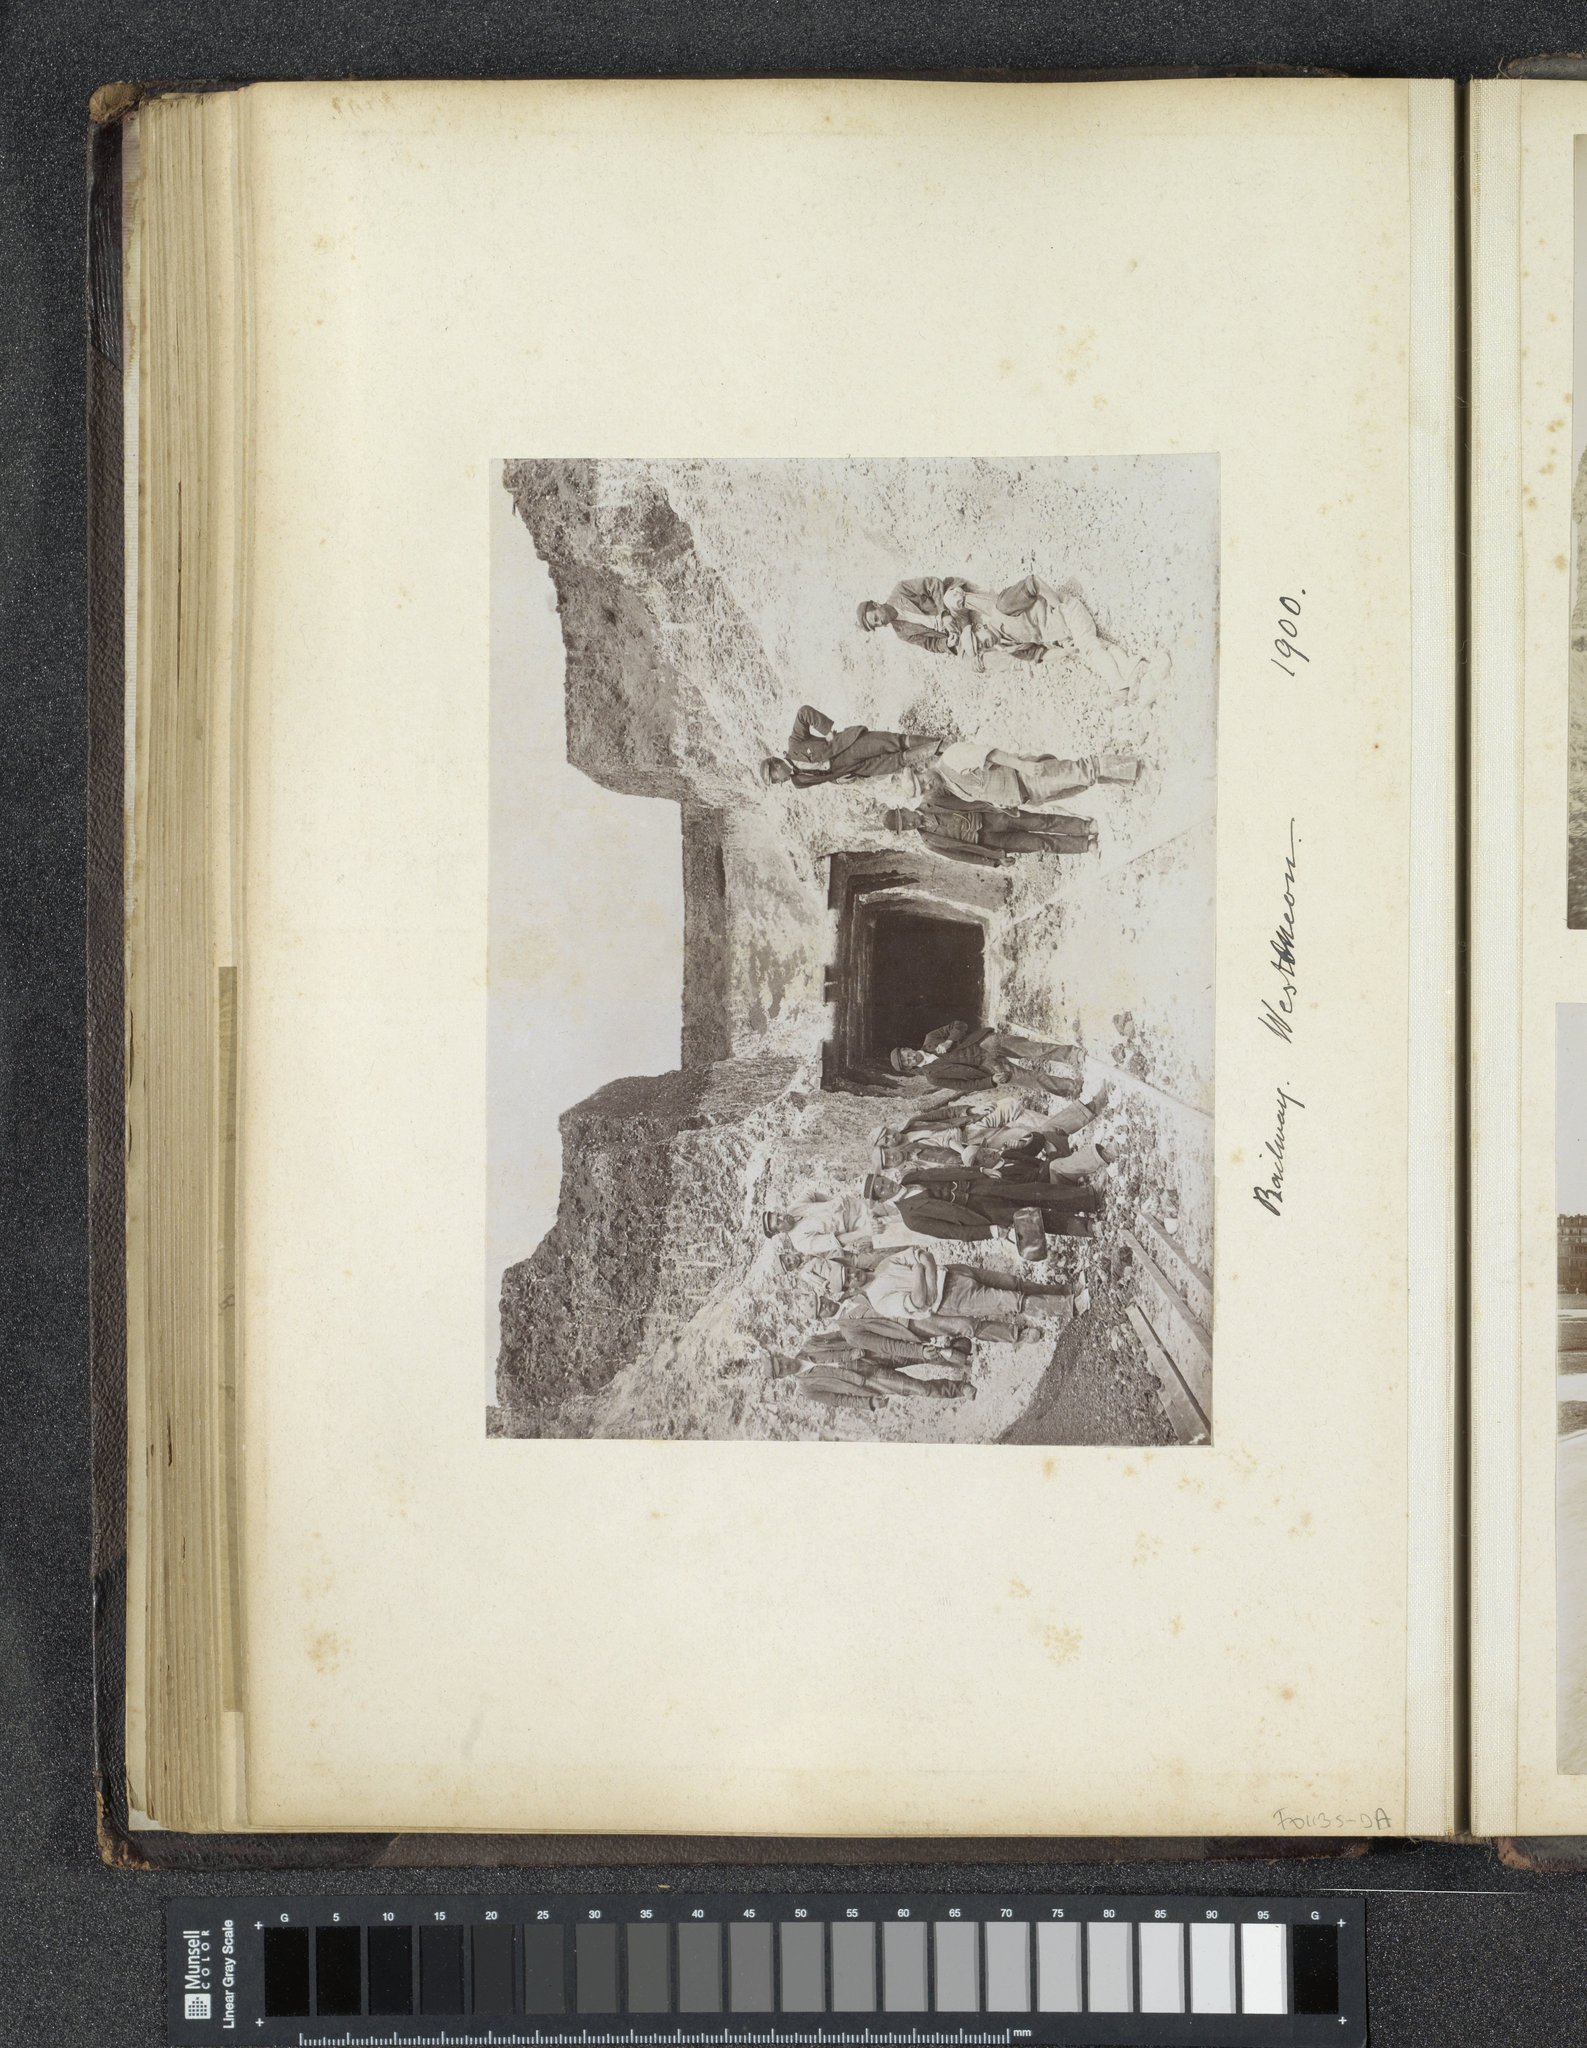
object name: photograph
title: Groep mannen bij een spoorwegtunnel in aanleg bij West Meon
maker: Anonymous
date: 1900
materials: paper, photographic support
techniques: albumen print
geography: west meon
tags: working class, labourers, railway, train, underground road, tunnel, building-site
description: Onderdeel van Reisalbum met foto's van bezienswaardigheden in Engeland en Frankrijk.